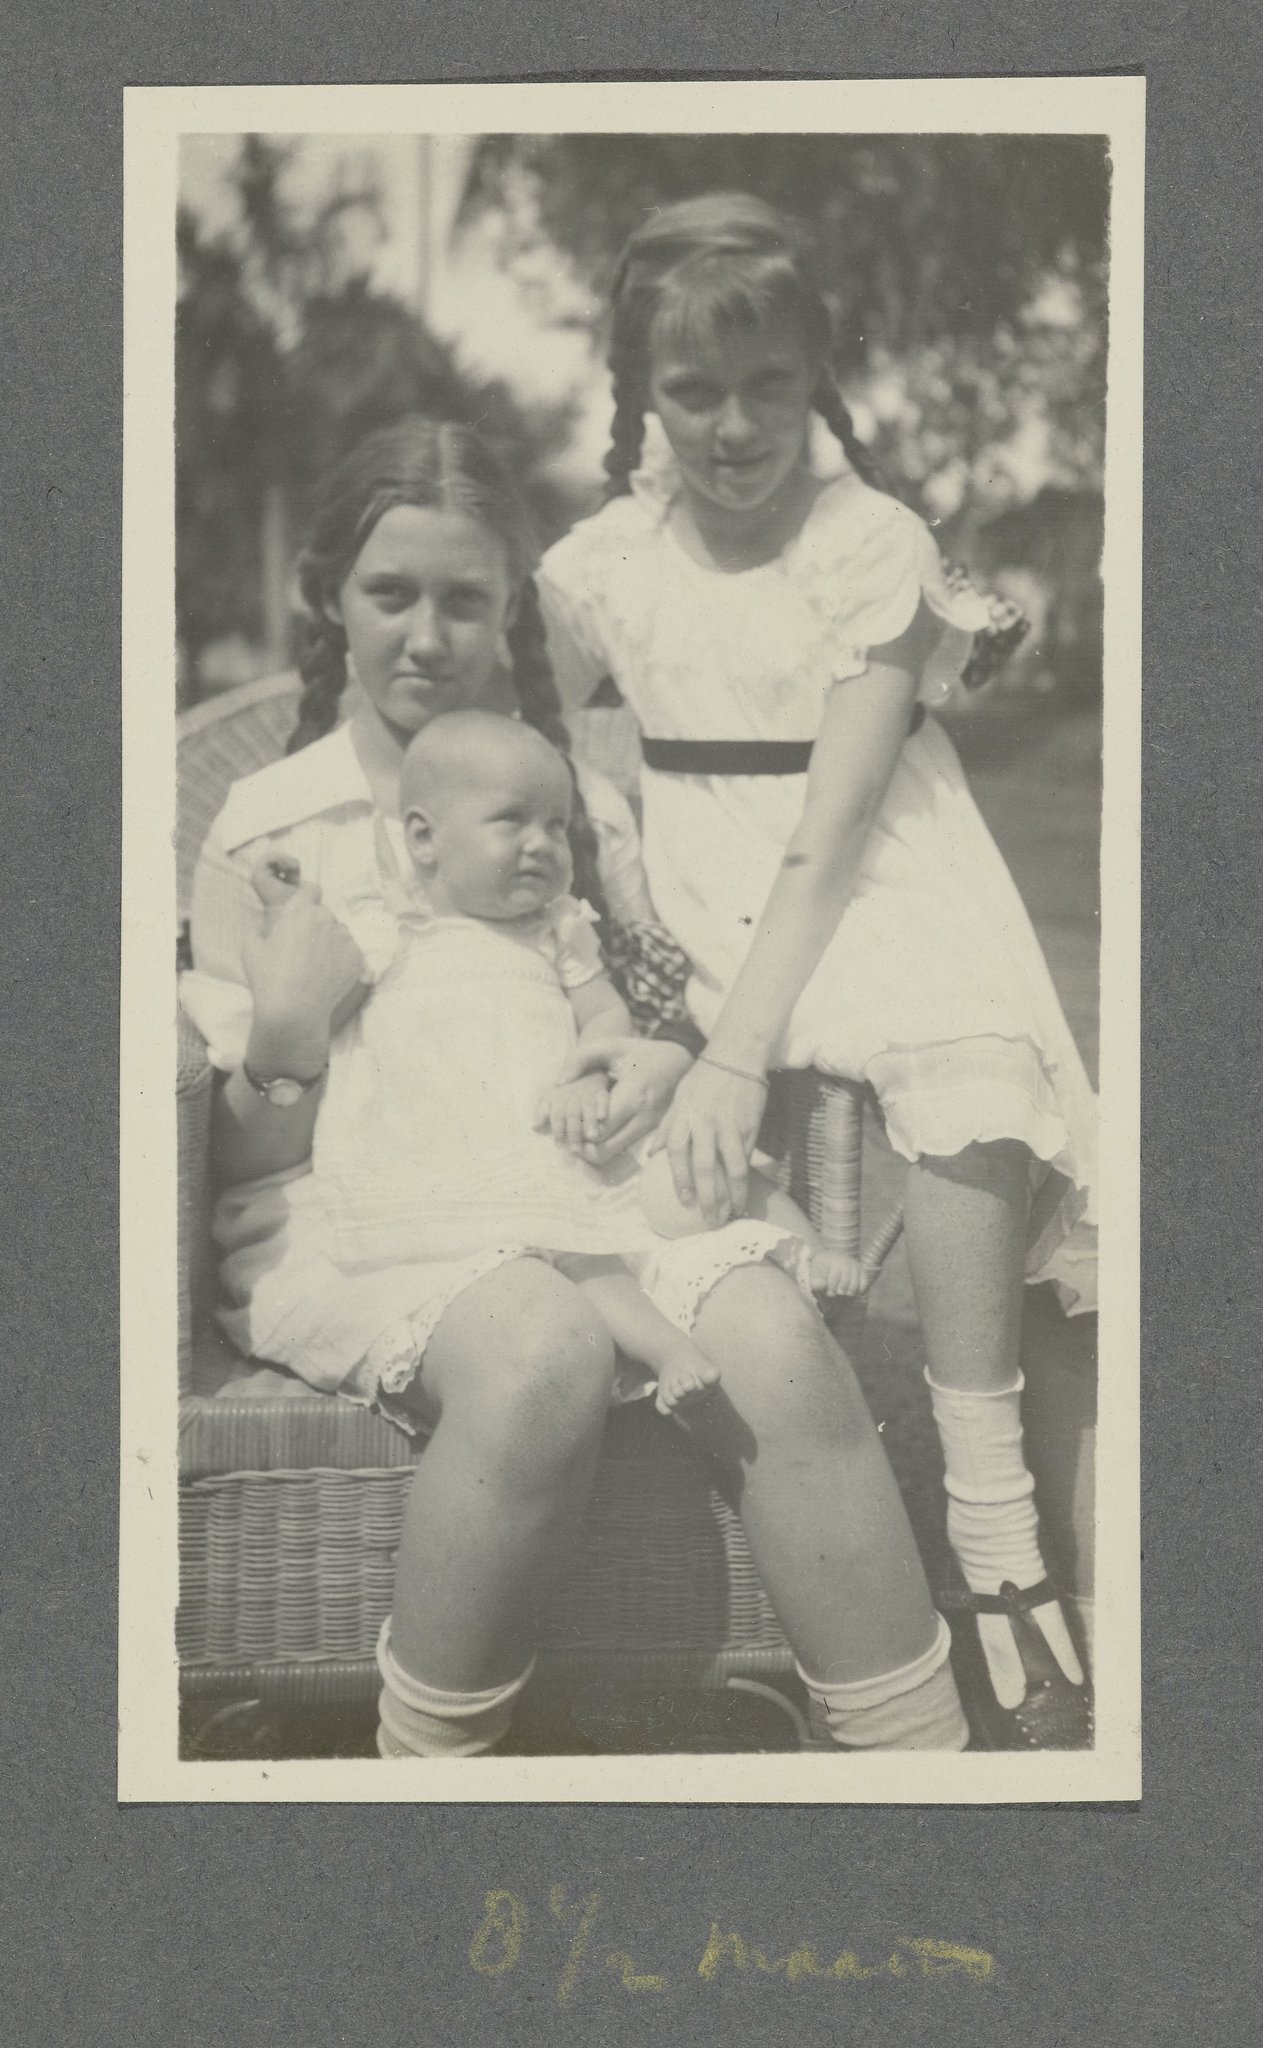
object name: photograph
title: Groepsportret van acht en een halve maand oude baby Klaas Kleiterp en Corrie en Els Bakker in Batavia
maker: klaas kleiterp (i)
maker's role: arts, officier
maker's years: 1892-1943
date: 1921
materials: paper, photographic support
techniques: gelatin silver print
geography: batavia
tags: child, infant, baby ~ the ages of man, dutch east indies, the, batavia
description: Onderdeel van Fotoalbum van de familie Kleiterp-Vermeulen met opnames van de kinderen Klaas en Tiny in Nederlands-Indië.